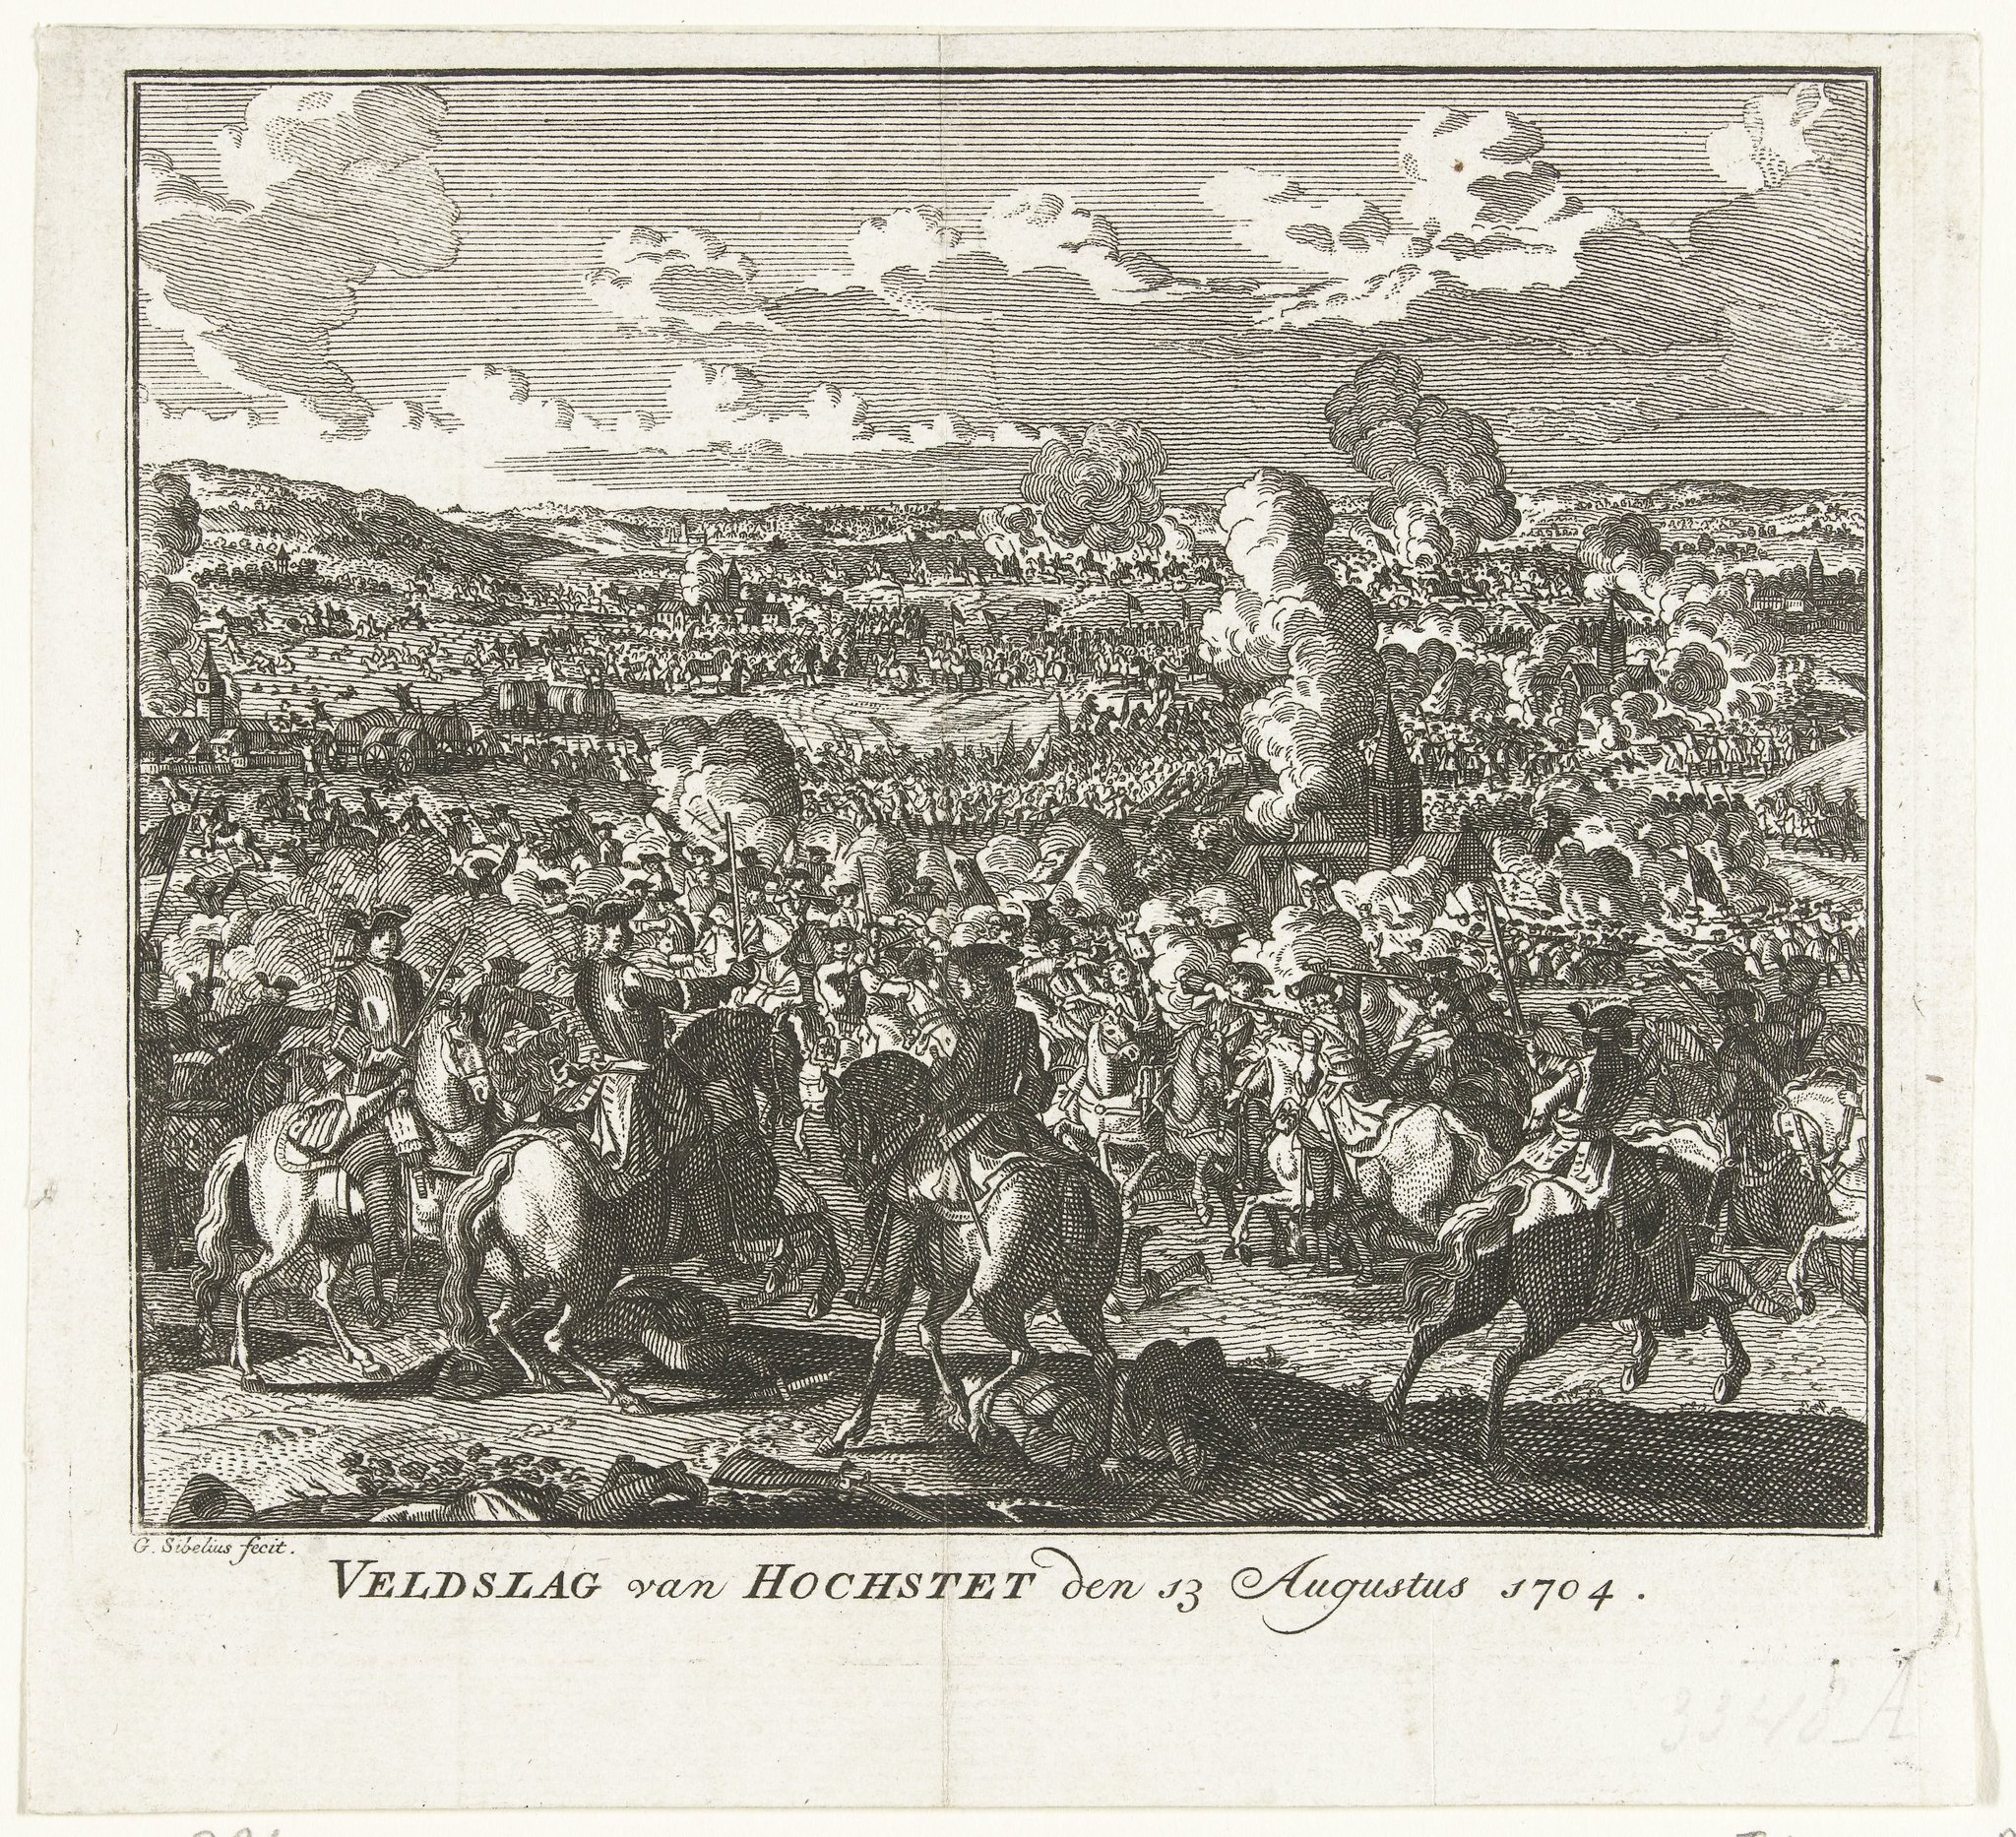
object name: print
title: Veldslag van Hochstet den 13 Augustus 1704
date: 1750-1752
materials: paper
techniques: etching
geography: northern netherlands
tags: eugenius van savoye, john churchill (1e hertog van marlborough), battle (+ land forces)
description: Niet in Frederik Muller; door het RPK toegevoegd nummer. Kopie naar de prent toegeschreven aan Adolf van der Laan (FMH 3348).. Gebruikt als illustratie in: J.L. Schuer, Nederlands merkwaardigste gebeurtenissen sedert byna twee eeuwen. Amsterdam: Steven van Esveldt, 1752.